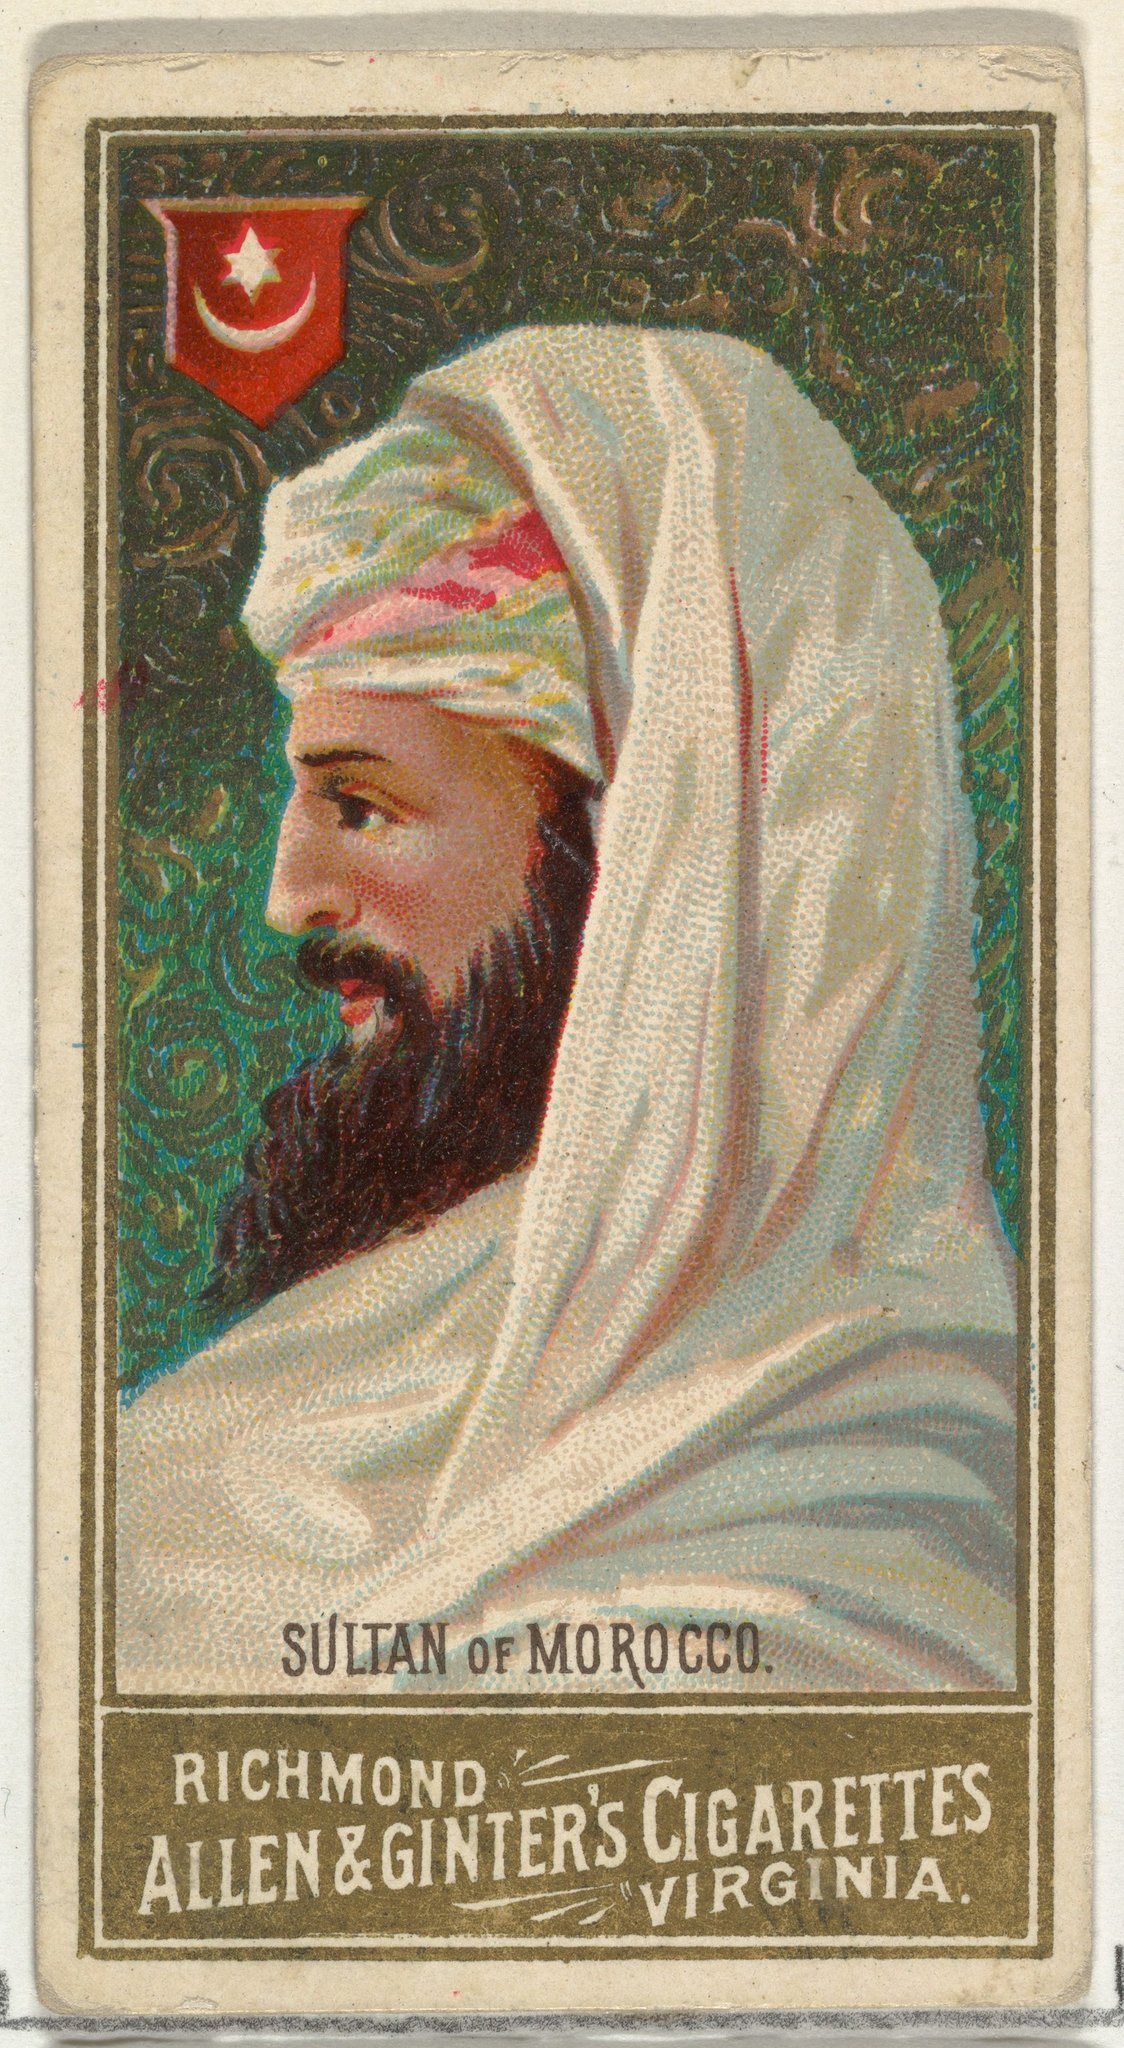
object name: print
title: Sultan of Morocco, from World's Sovereigns series (N34) for Allen & Ginter Cigarettes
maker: allen & ginter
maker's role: publisher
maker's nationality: american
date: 1889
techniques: color lithograph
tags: men,profiles